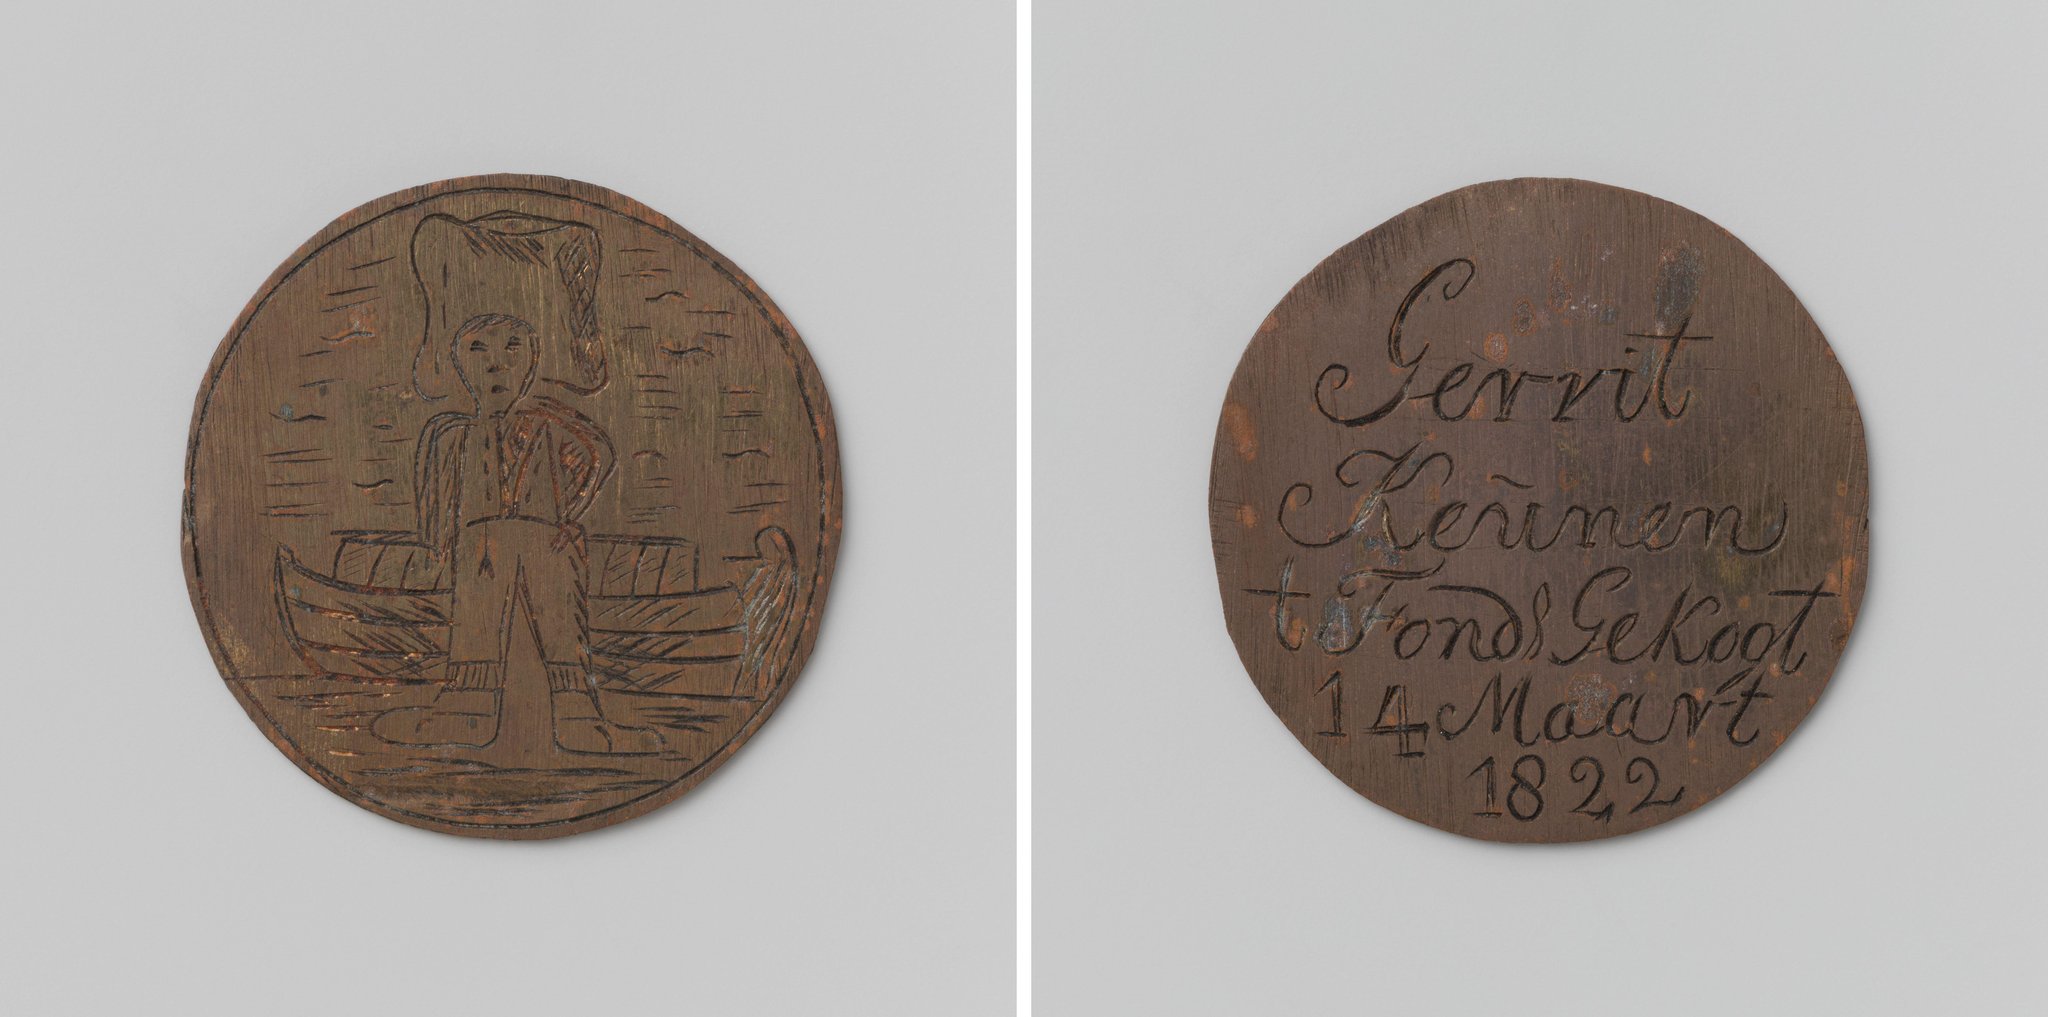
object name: medal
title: Korendragers- en -stortersgilde van Amsterdam, gildepenning van Gerrit Keunen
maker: Anonymous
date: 1822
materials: copper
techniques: engraving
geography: amsterdam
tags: amsterdam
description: Koperen penning. Voorzijde: man met last op hoofd en face, staande voor lichterschuit. Keerzijde: opschrift